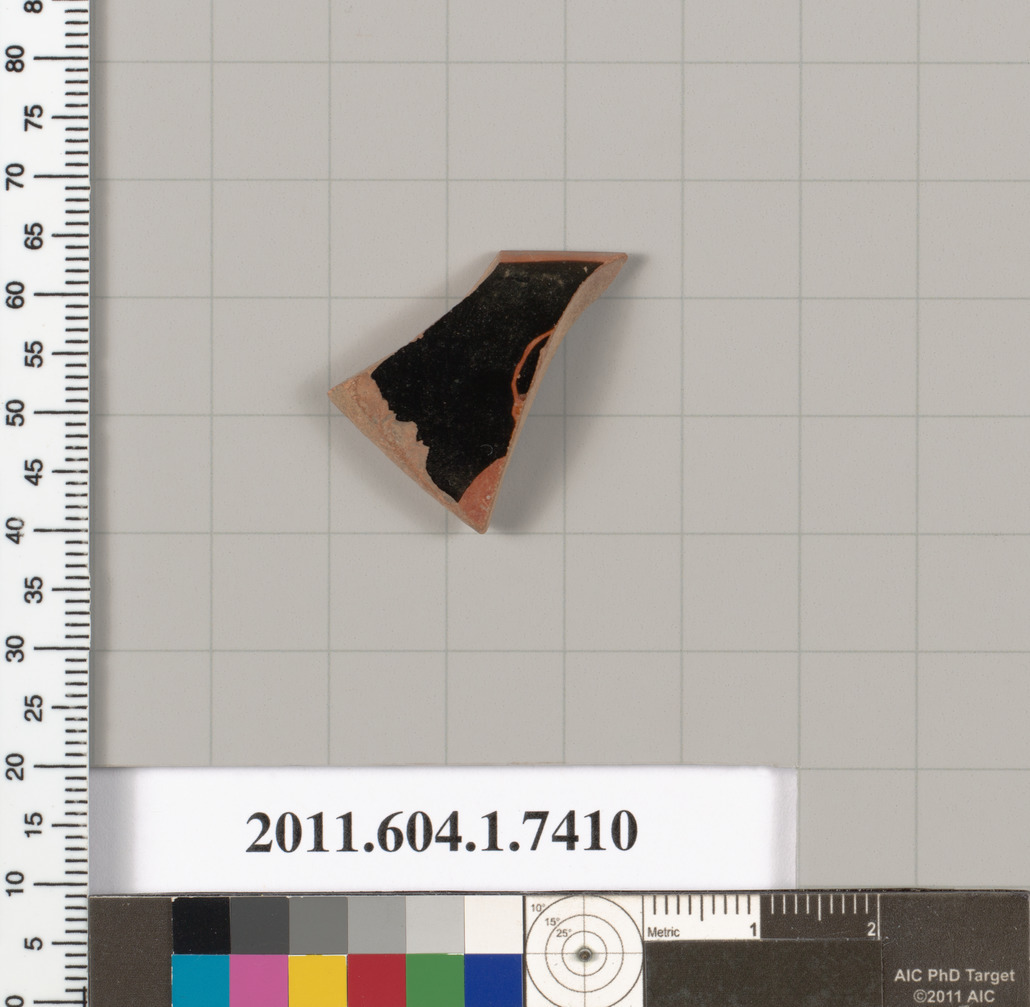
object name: kylix fragment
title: Terracotta rim fragment of a kylix (drinking cup)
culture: greek, attic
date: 490-470 BCE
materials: terracotta